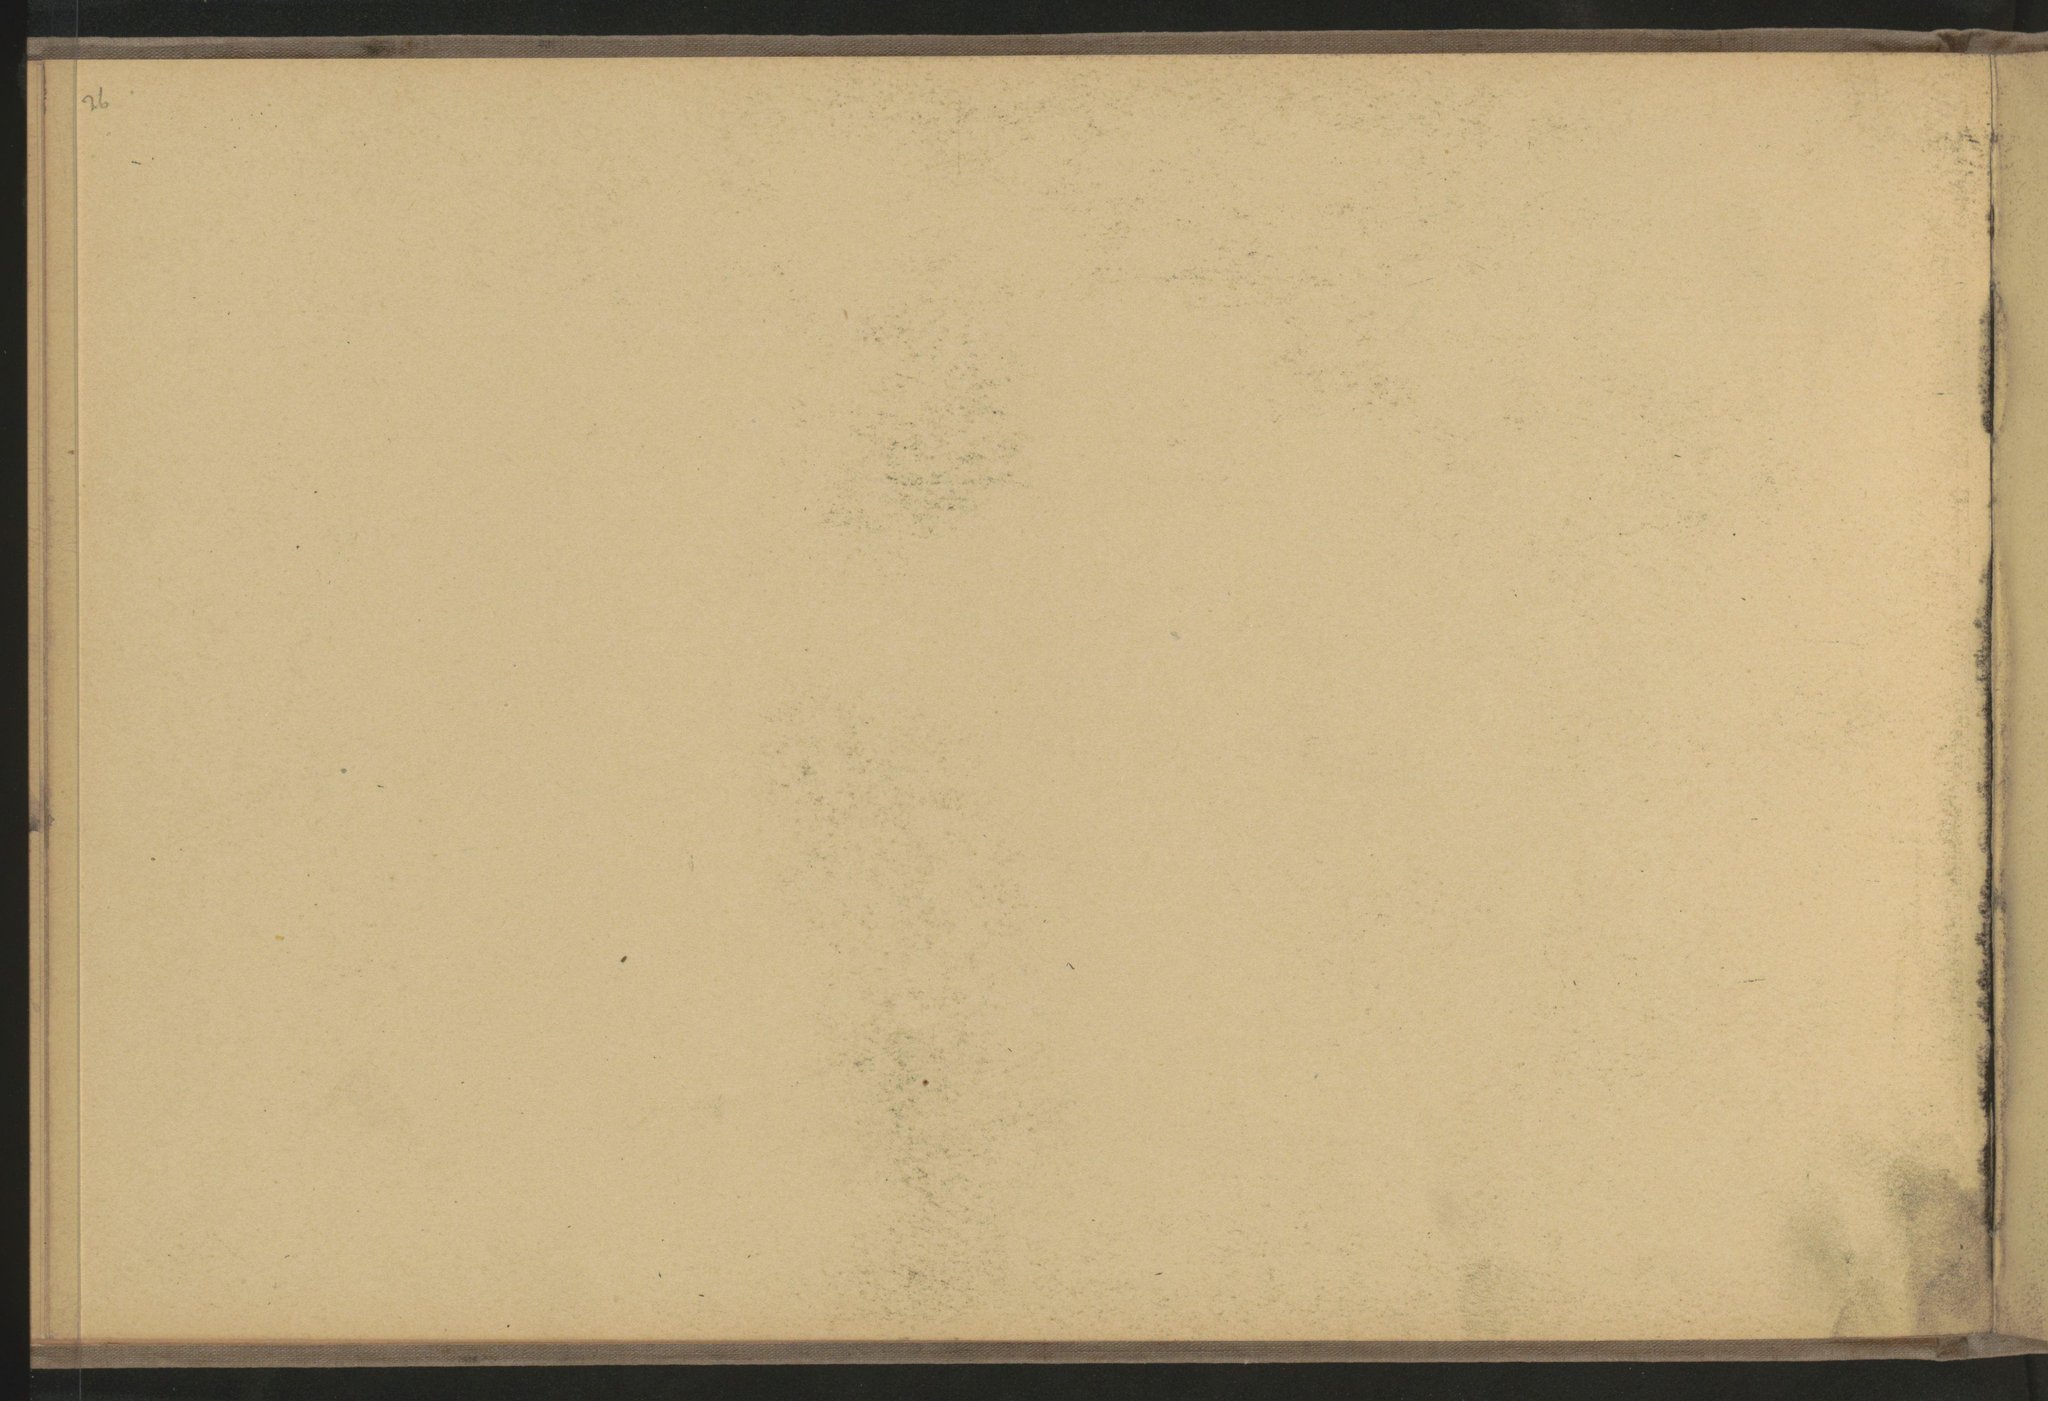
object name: sketchbook leaf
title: Abklatsch van een krijttekening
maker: willem witsen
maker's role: draughtsman, painter, print maker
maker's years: 1860-1923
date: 1901-1907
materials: paper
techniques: printmaking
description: De tekening is eruit gescheurd. Pagina 26 uit een schetsboek met 60 bladen.